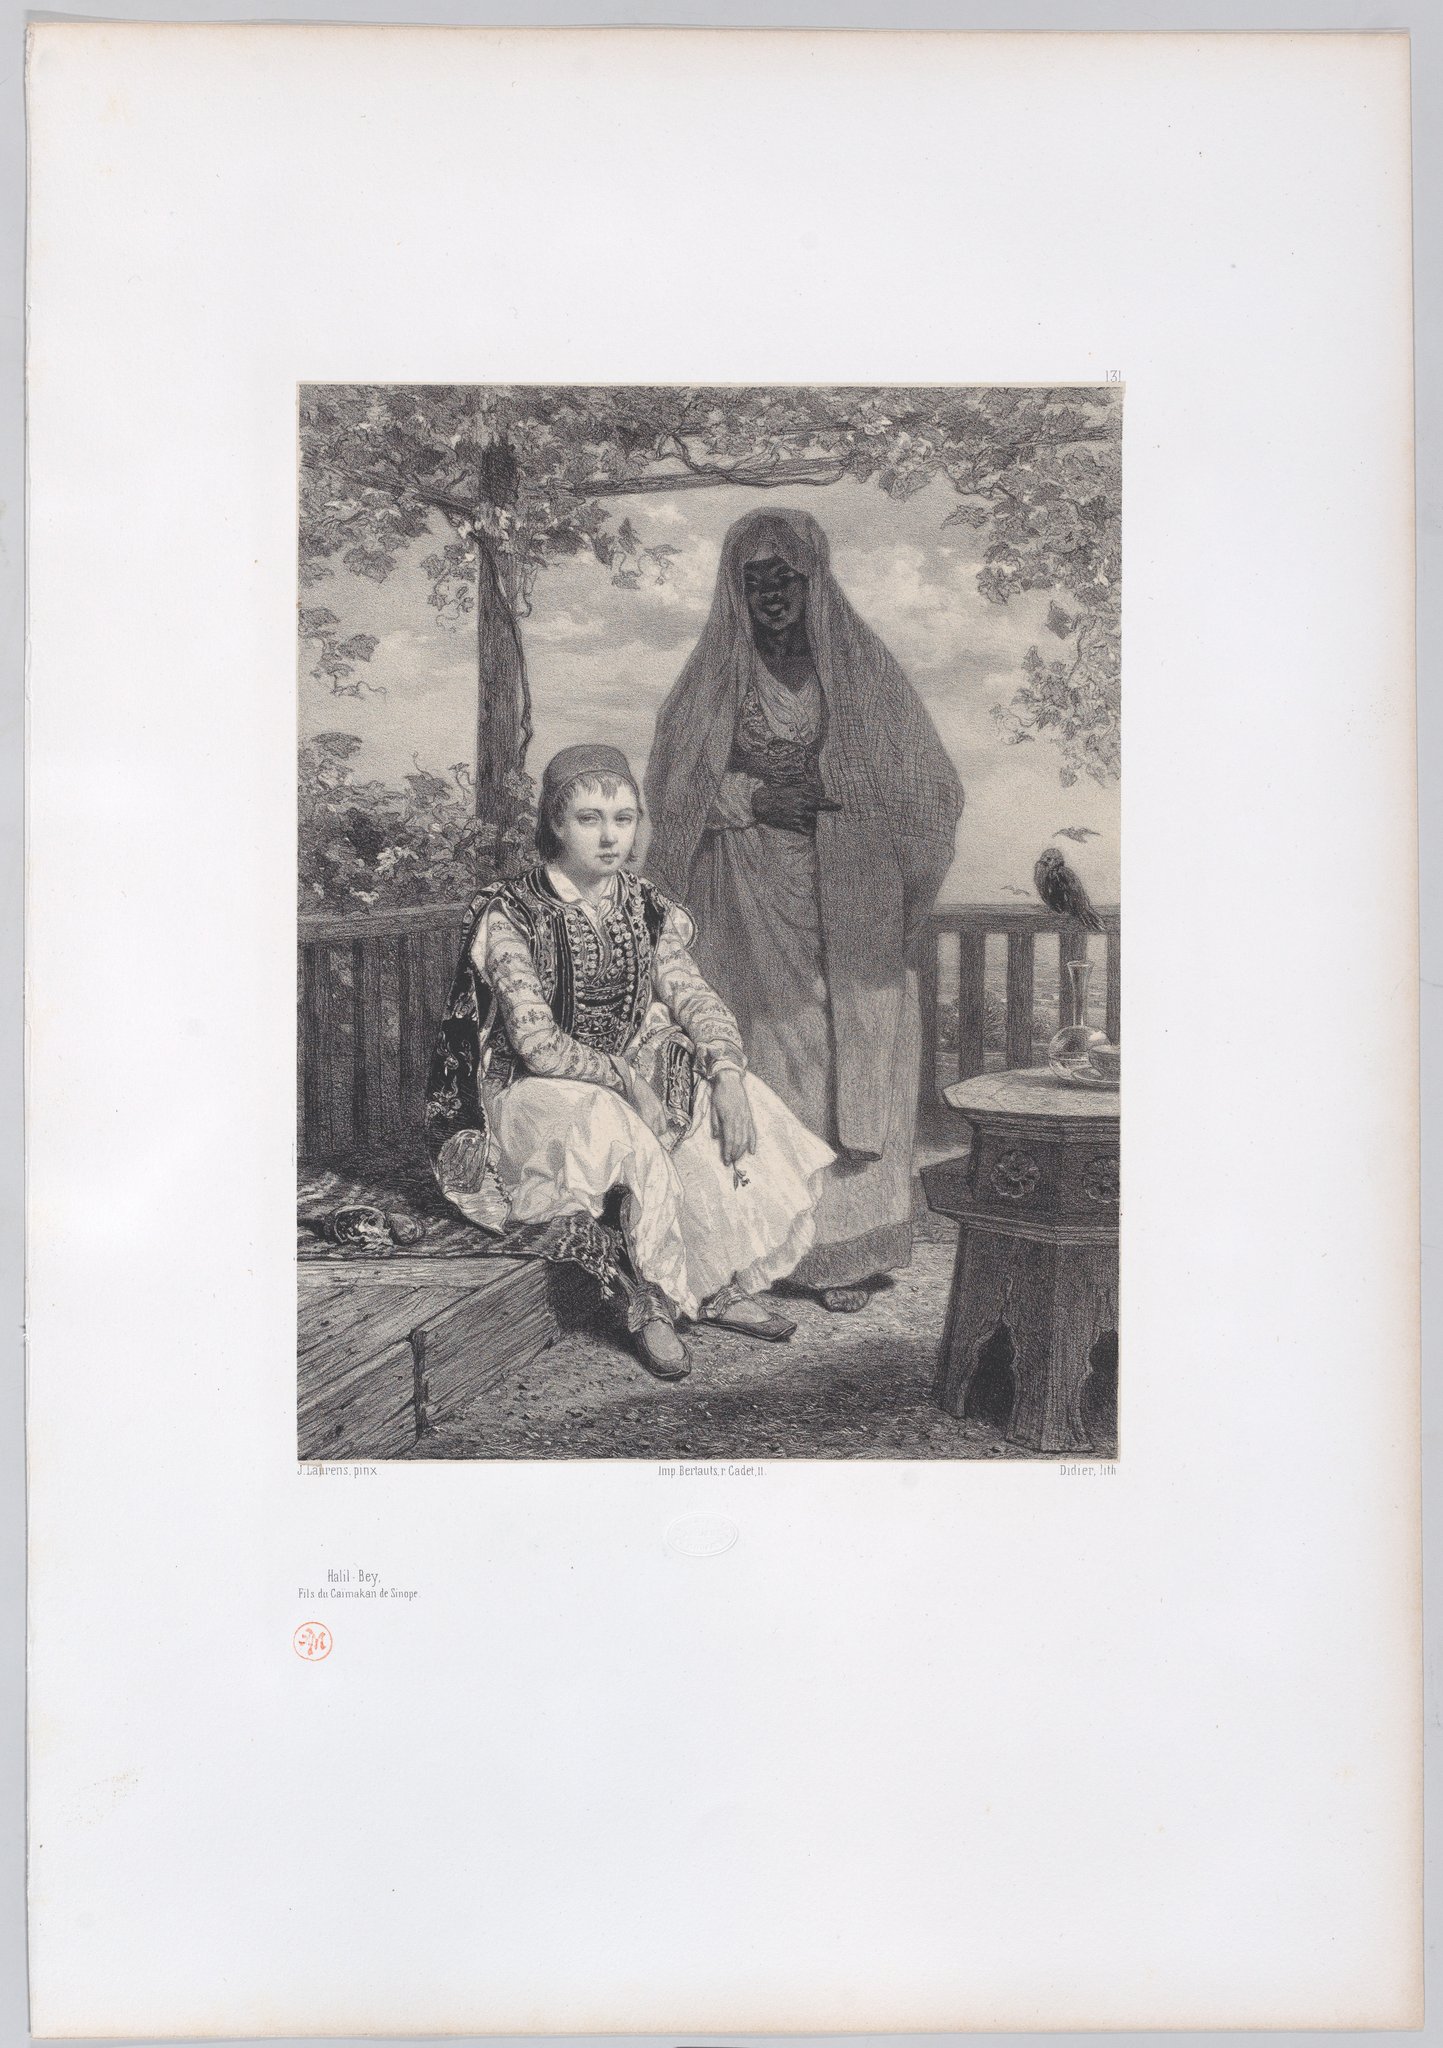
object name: print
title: Halil Bey, fils du Caïmakan de Sinope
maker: jules didier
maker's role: artist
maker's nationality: french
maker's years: 1831-1914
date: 1850-1914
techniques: printmaking, lithograph